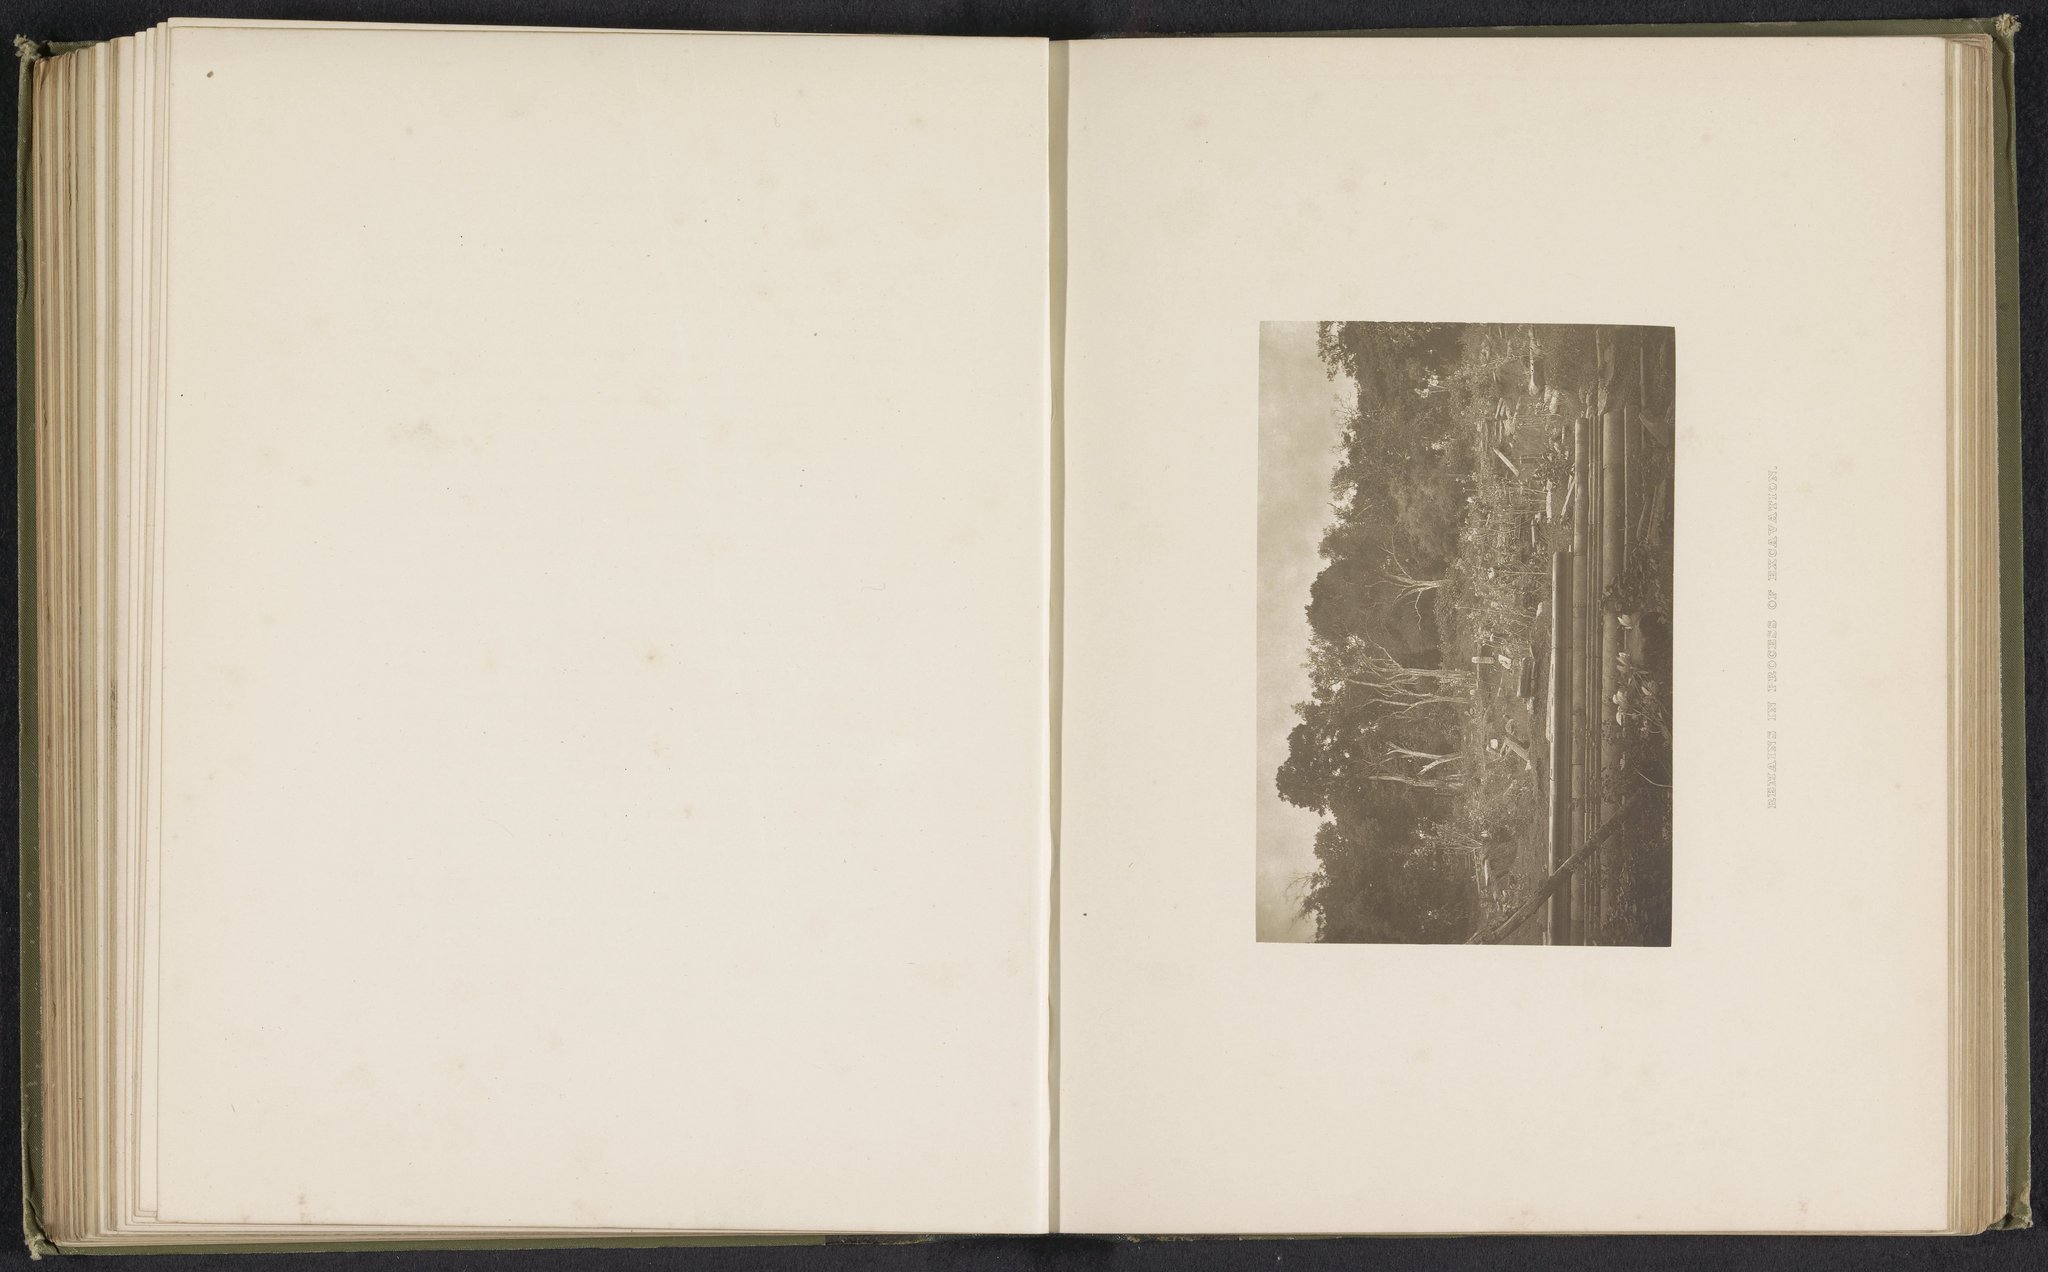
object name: page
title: Ruins at an excavation site in Anuradhapura, Sri Lanka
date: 1896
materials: paper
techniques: woodburygravure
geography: anuradhapura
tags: ruin of a building ~ architecture, excavation ~ archaeology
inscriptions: title: ‘REMAINS IN PROCESS OF EXCAVATION.’